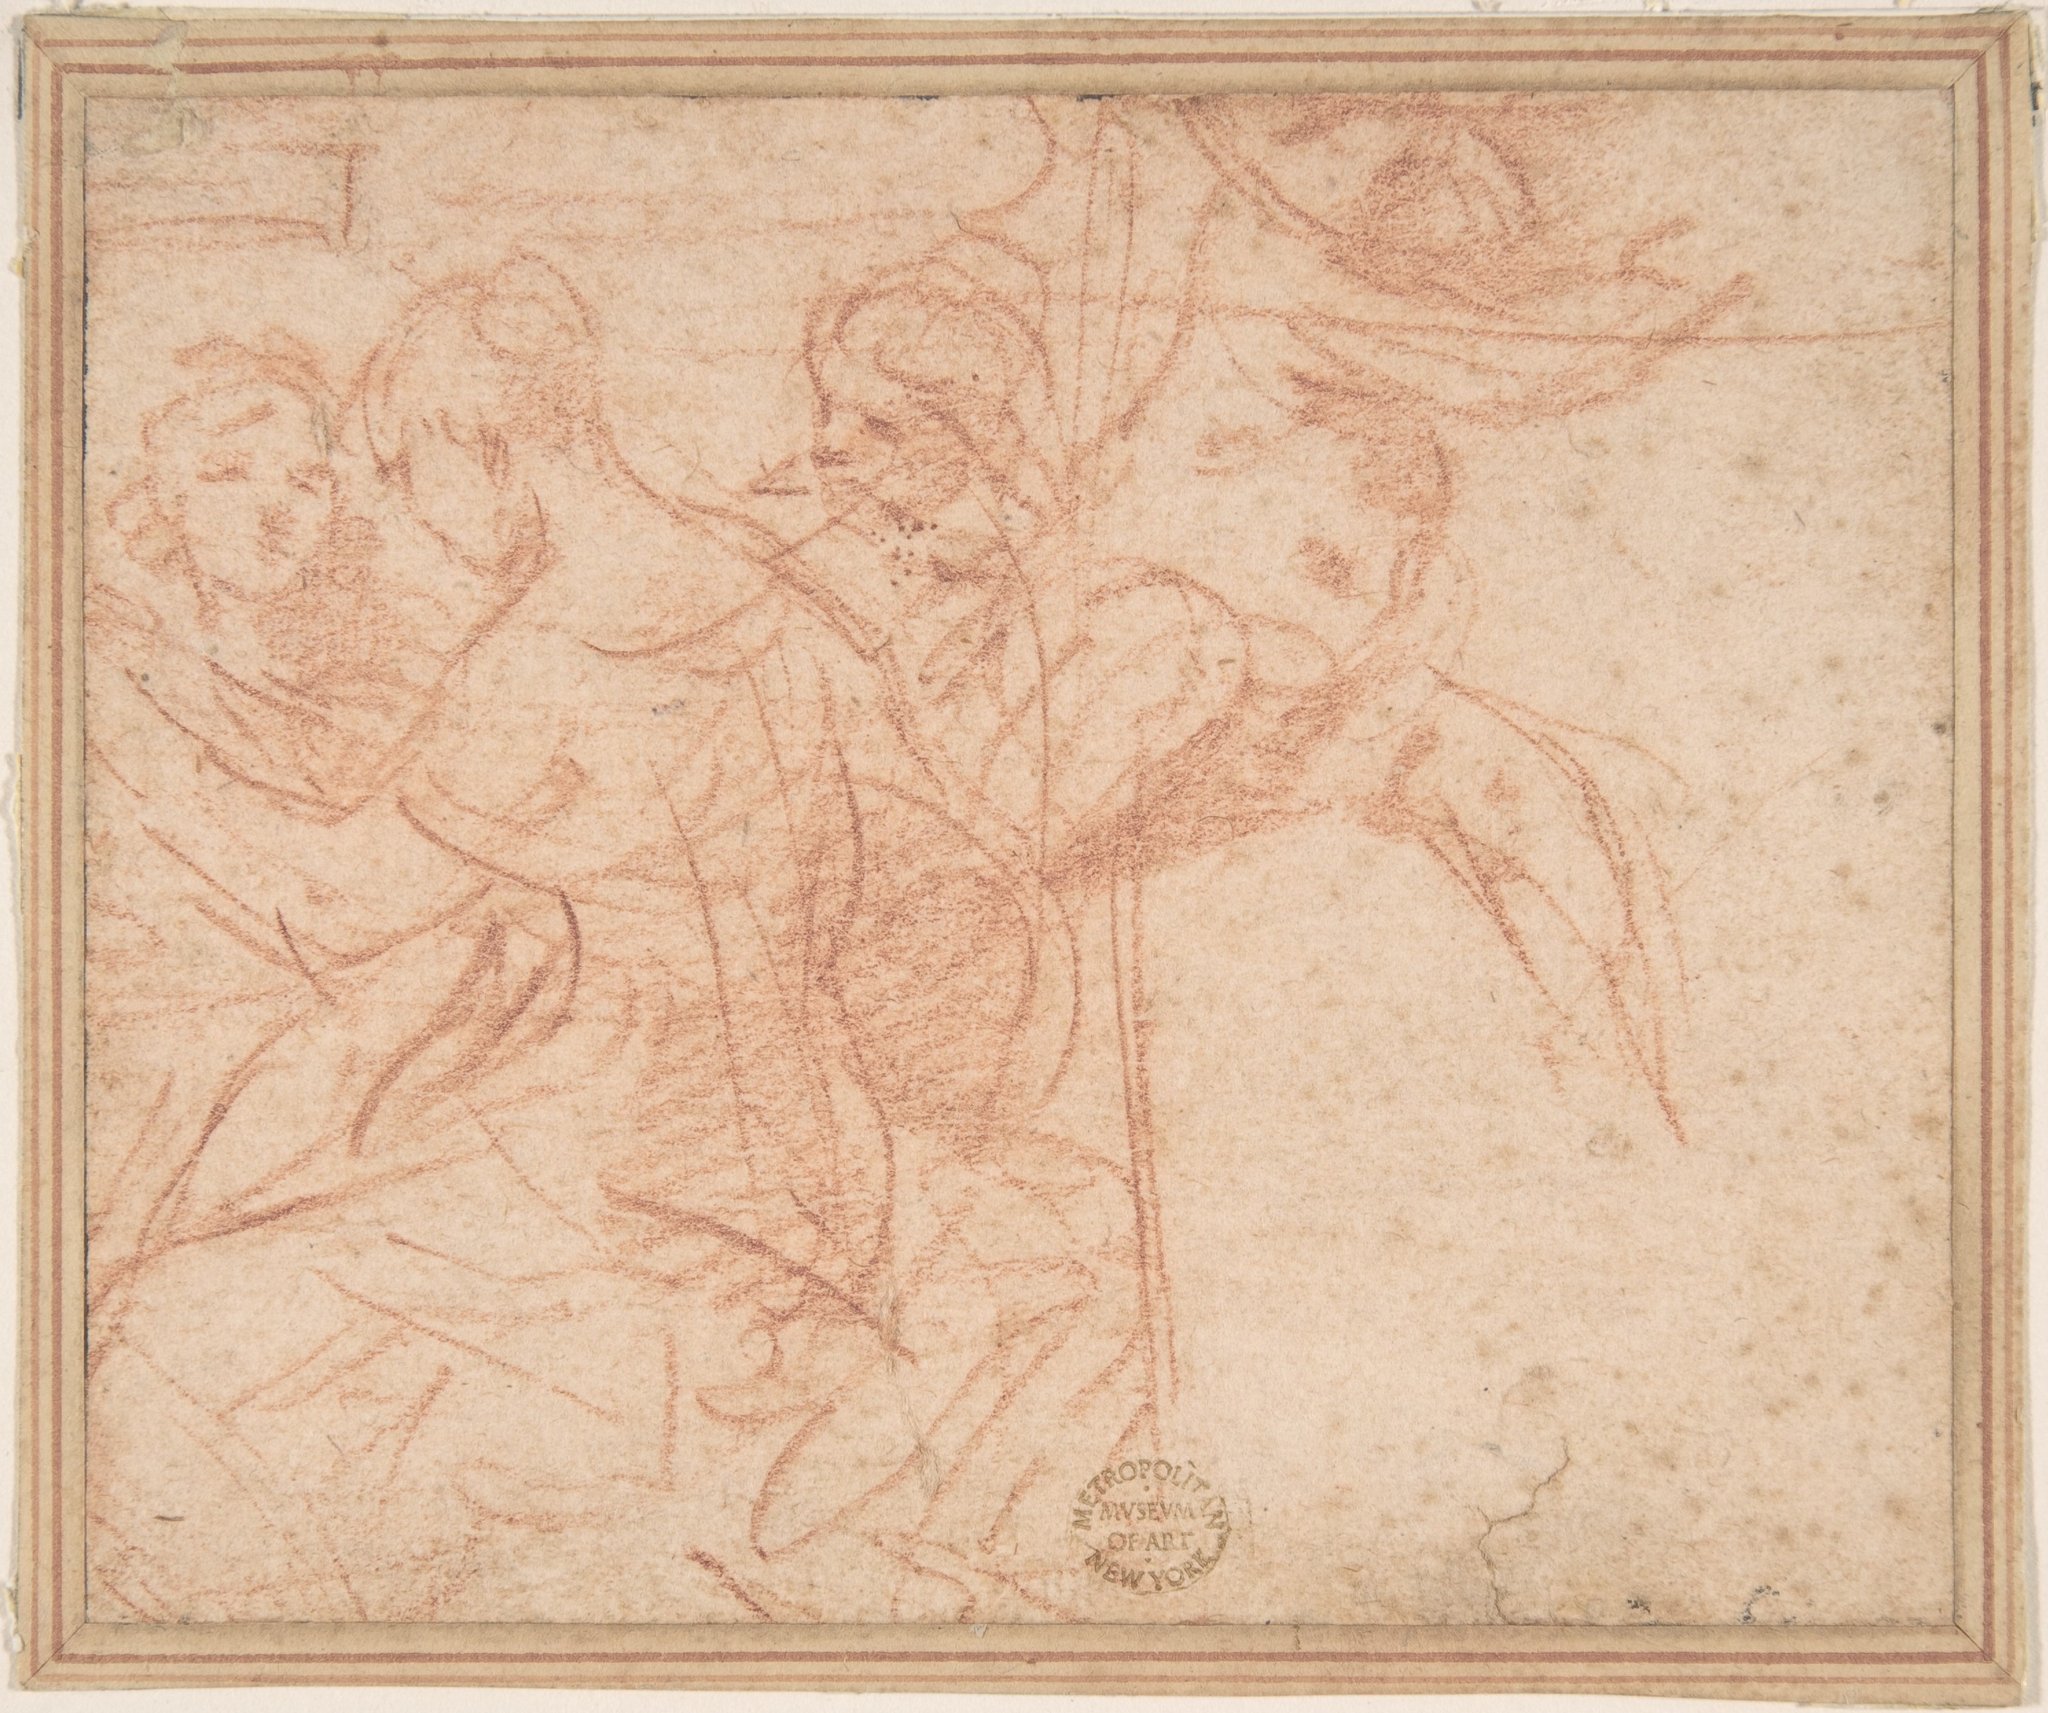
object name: drawing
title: Three Female Figures and Seated Putto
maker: anonymous, italian, roman-bolognese, 17th century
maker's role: artist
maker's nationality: italian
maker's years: 1600-1700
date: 1601-1700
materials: chalk, paper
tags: women,putti